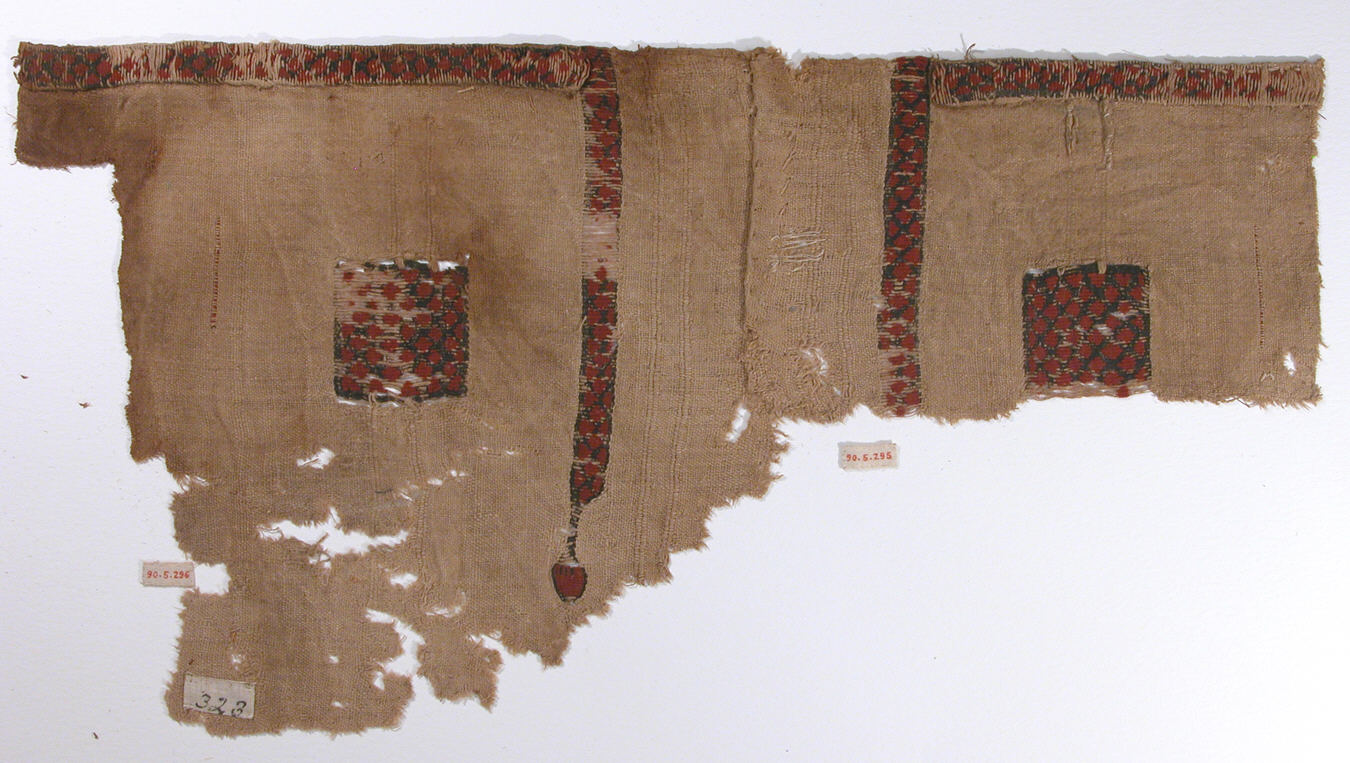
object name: textile fragment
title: Fragment of a Tunic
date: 301-500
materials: linen, wool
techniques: weave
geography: egypt